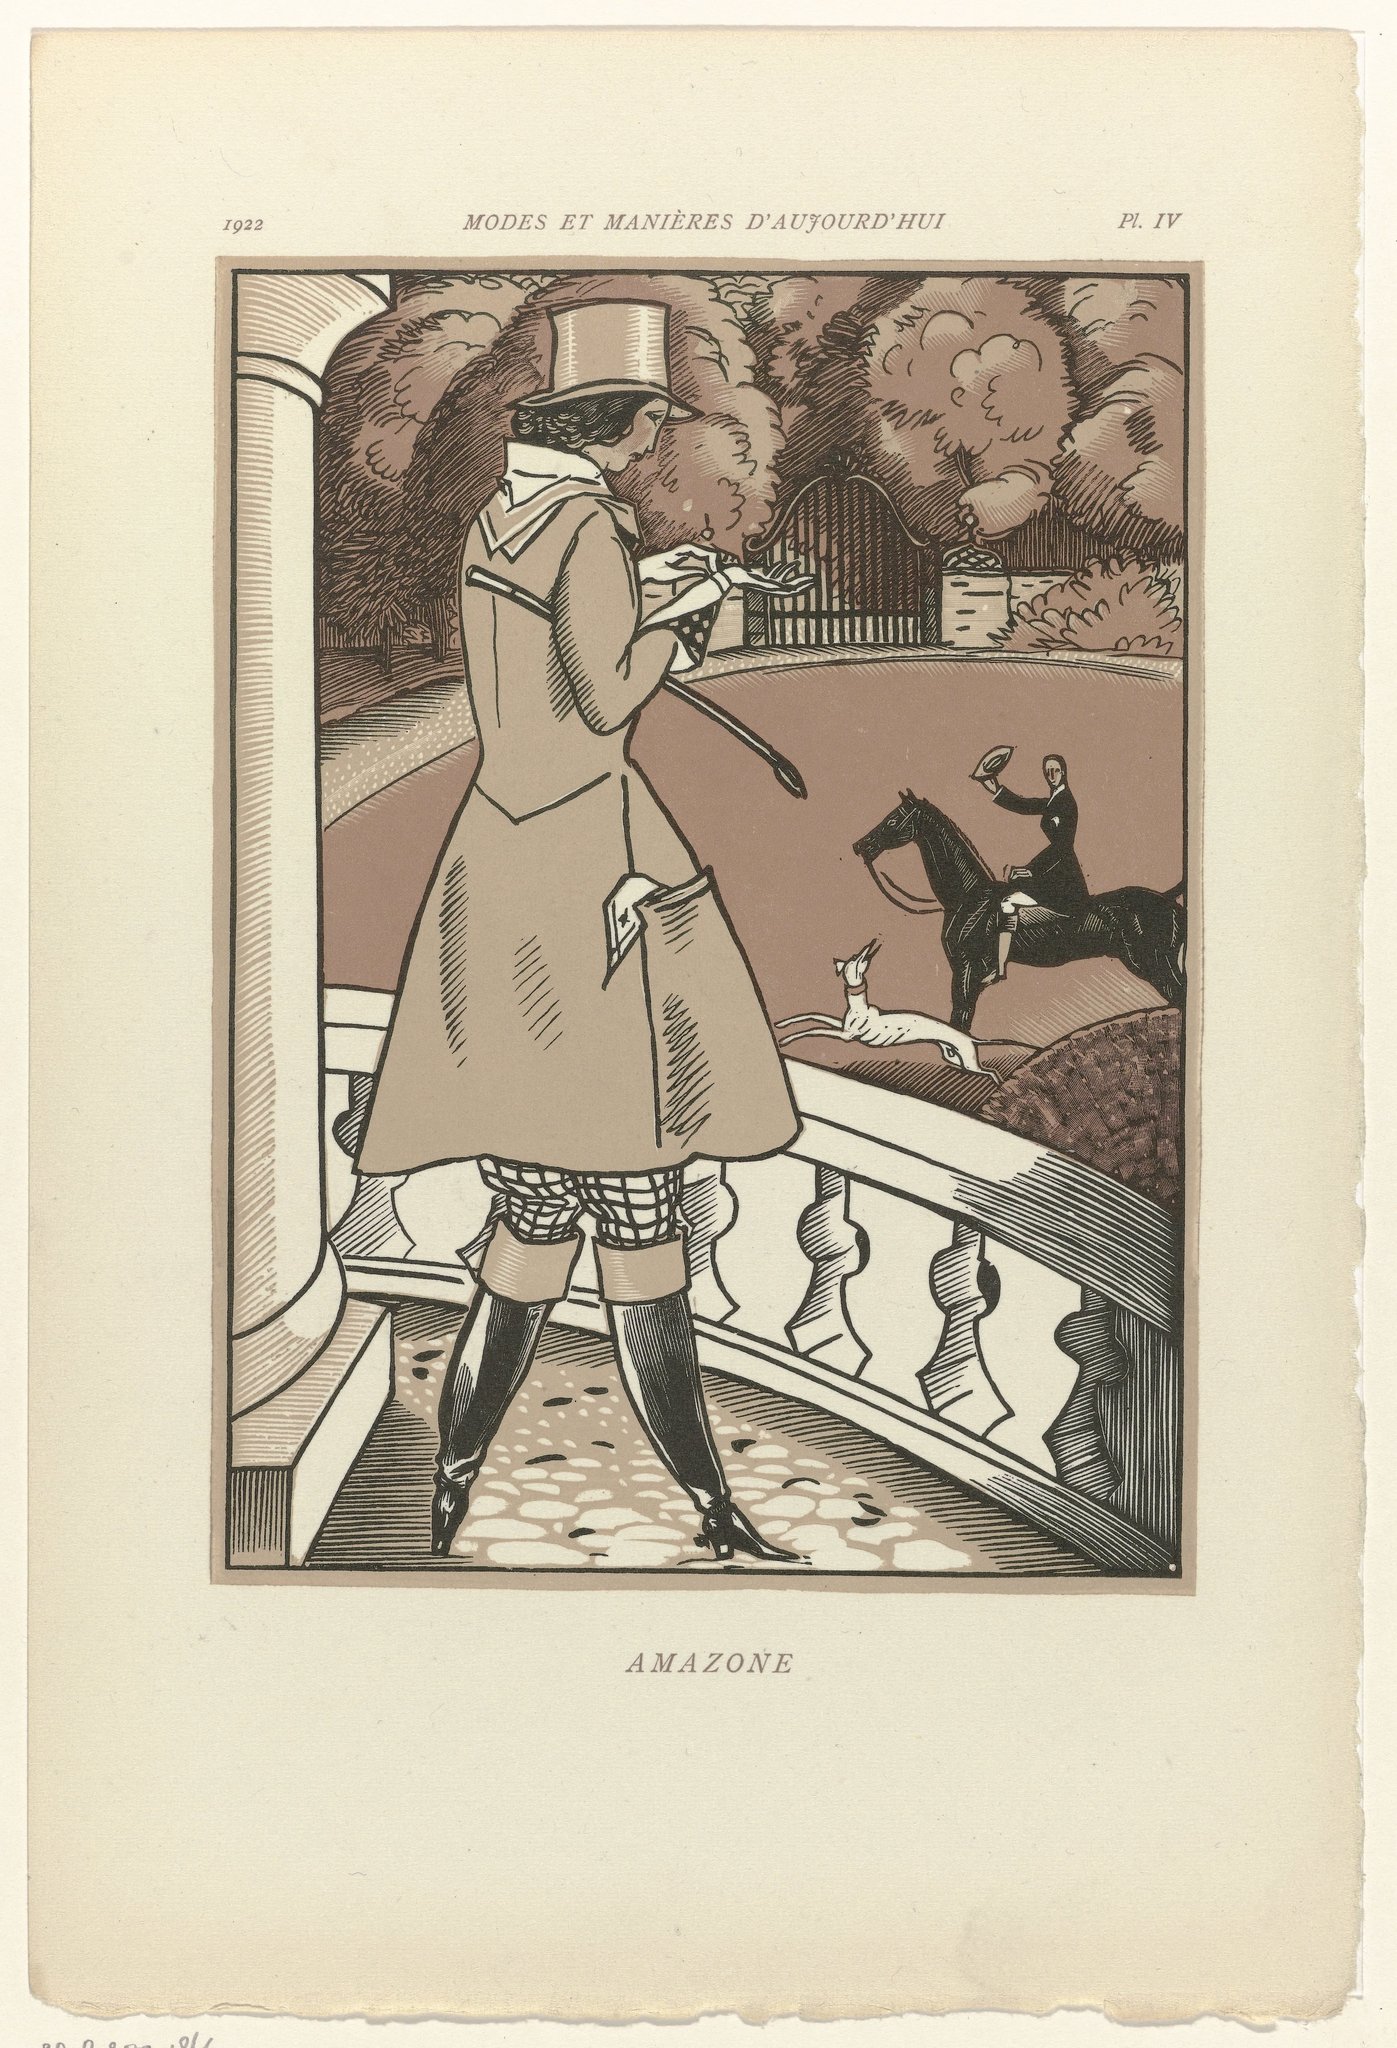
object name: fashion print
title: Modes et Manières d'Aujourd'hui, 1922, Pl. 4 : Amazone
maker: Anonymous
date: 1922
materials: paper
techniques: pochoir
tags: riding a horse, ass, or mule; rider, horseman, boots (+ women's clothes), trousers, breeches (+ women's clothes), coat (+ women's clothes), baring the head, lifting one's hat, fashion plates, gloves, mittens, etc. (+ women's clothes), balcony, dog, whip, ensembles of pieces of clothing (riding costume) (+ women's clothes)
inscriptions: title: ‘MODES ET MANIÈRES D'AUJOURD'HUI’, caption: ‘AMAZONE’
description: Een vrouw, staande bij een balustrade, in een amazonekostuum (rijkostuum). Zij is bezig haar handschoen aan te doen. Zweep onder de arm. Op de binnenplaats staat een ruiter die zijn hoed afneemt. Naast zijn paard een hazewindhond. De prent maakt deel uit van een serie van 12 houtsneden van Fernand Siméon, met teksten van Paul Valery, voor het zevende deel (10e année 1922) van Modes et Manières d'Aujourd'hui. Elke uitgave had een oplage van slechts 300 stuks en was exclusief gewijd aan één kunstenaar die 12 prenten ontwierp rond een bepaald thema. In deze serie staat het 'leven van de modieuze vrouw in de maatschappij' centraal.